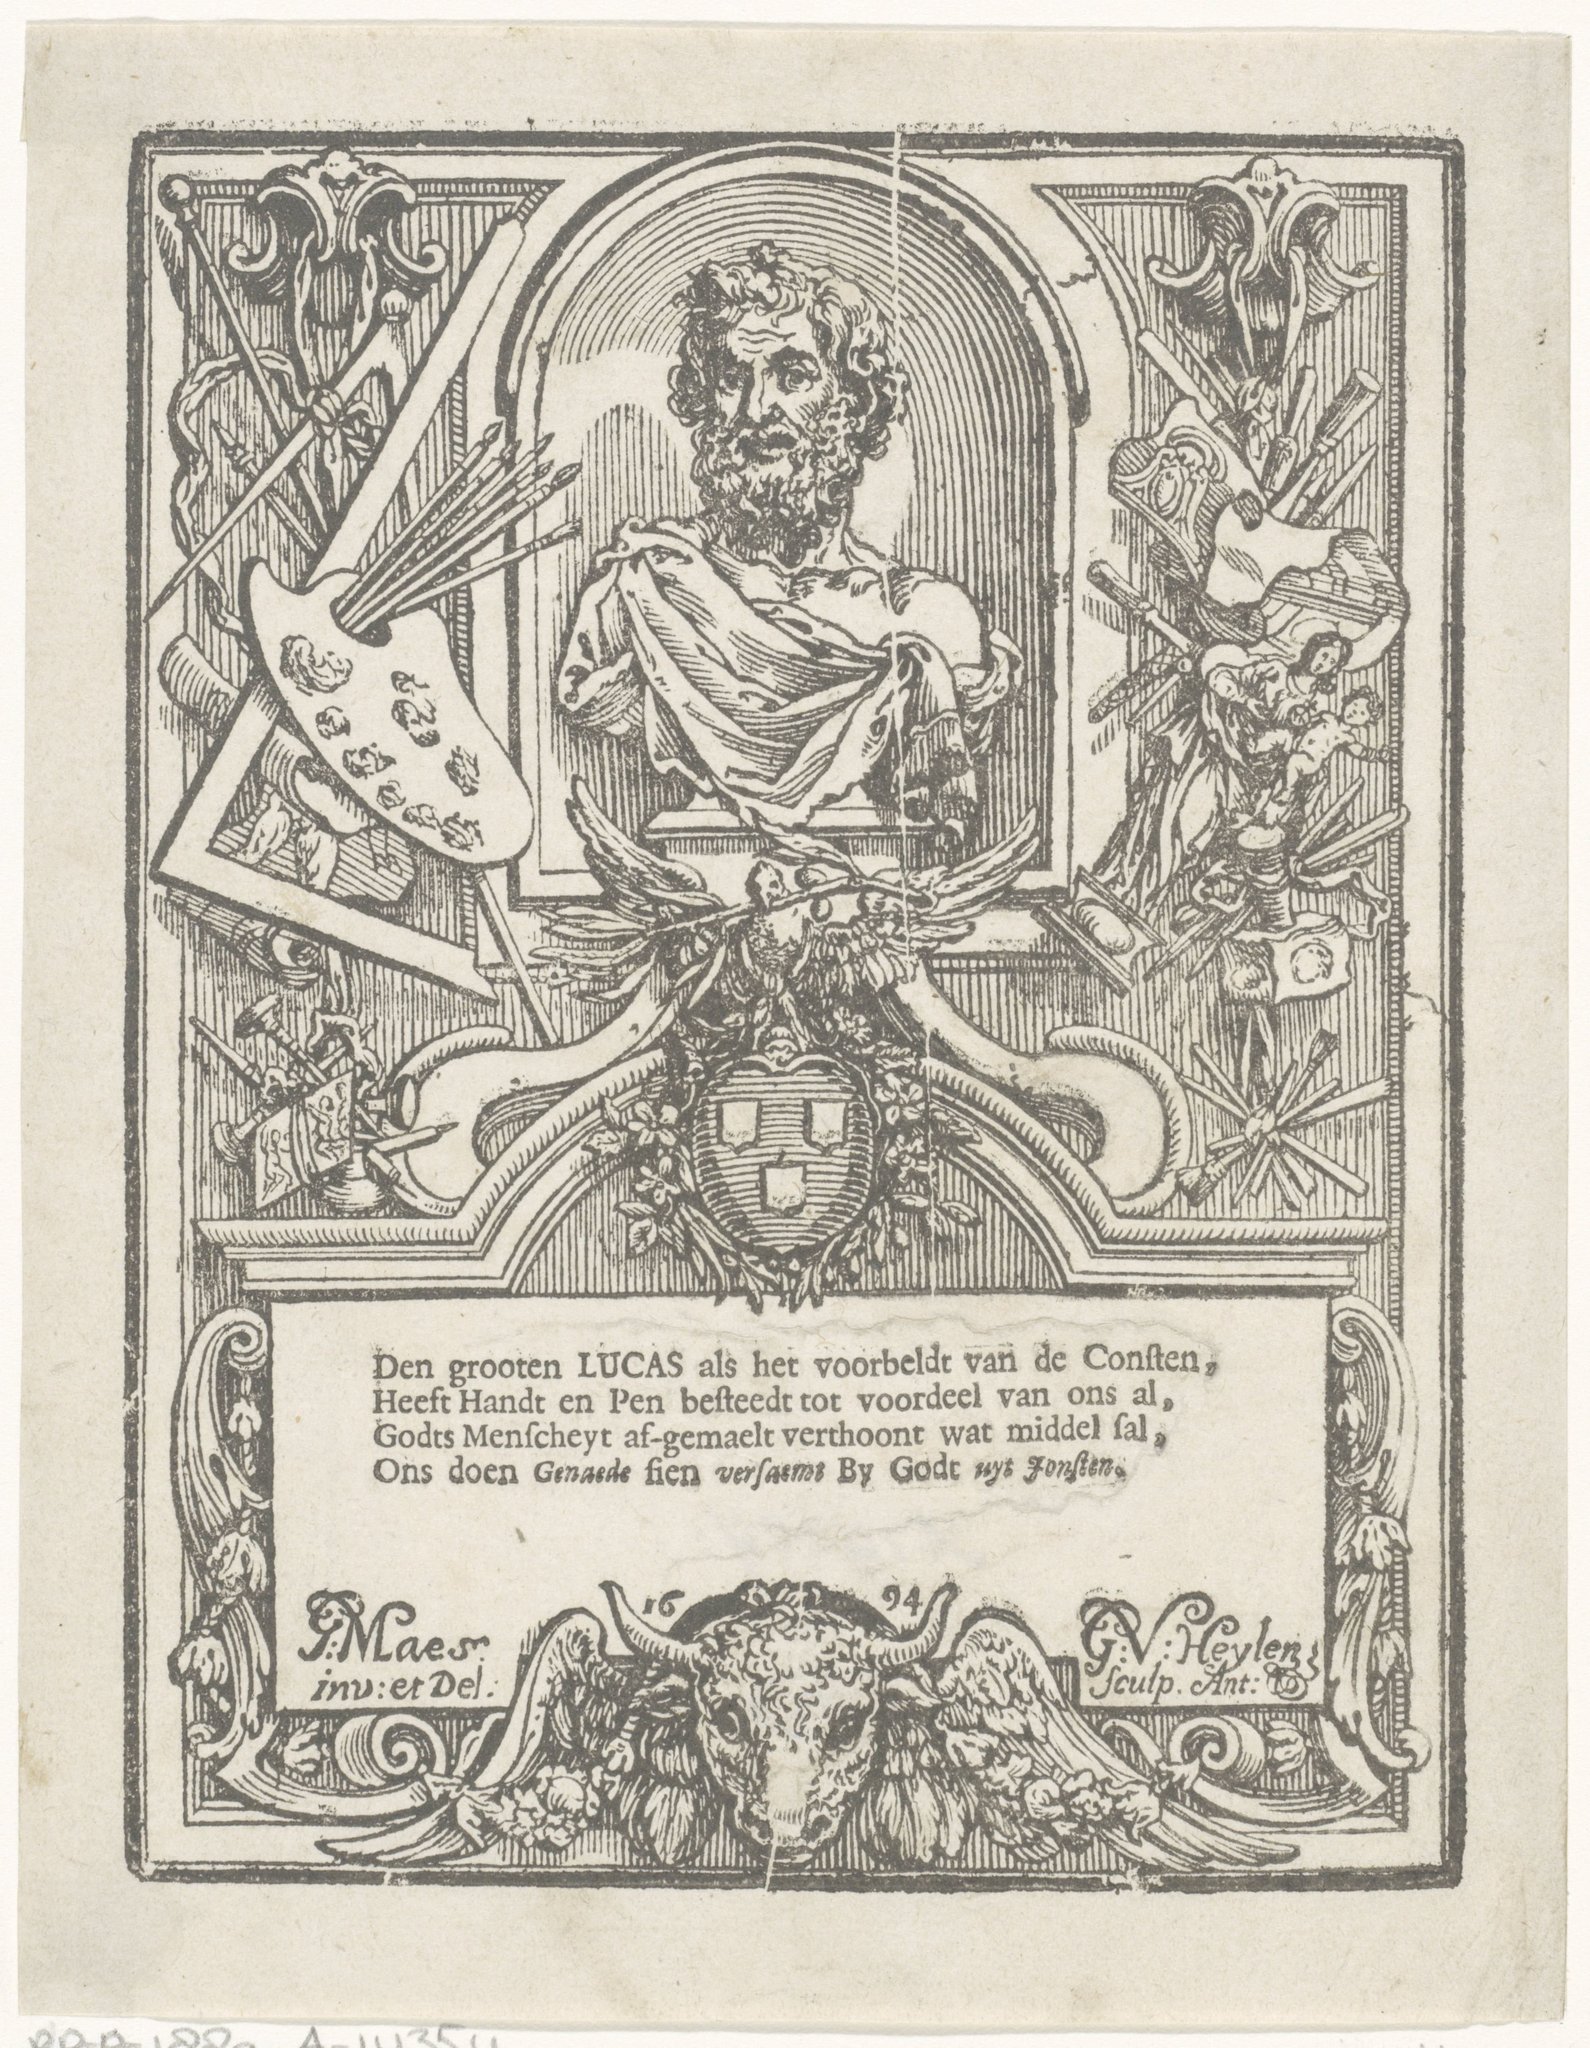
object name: print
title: Buste van de heilige Lucas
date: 1694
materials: paper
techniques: letterpress printing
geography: antwerp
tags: st. luke as patron, piece of sculpture, reproduction of a piece of sculpture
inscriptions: date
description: Buste van de heilige Lucas onder een toog. Daar omheen meerdere allegorische objecten uit de schilder- en beeldhouwkunst, waaronder het schilderswapen en een os. In een kader vier regels Nederlandse tekst.